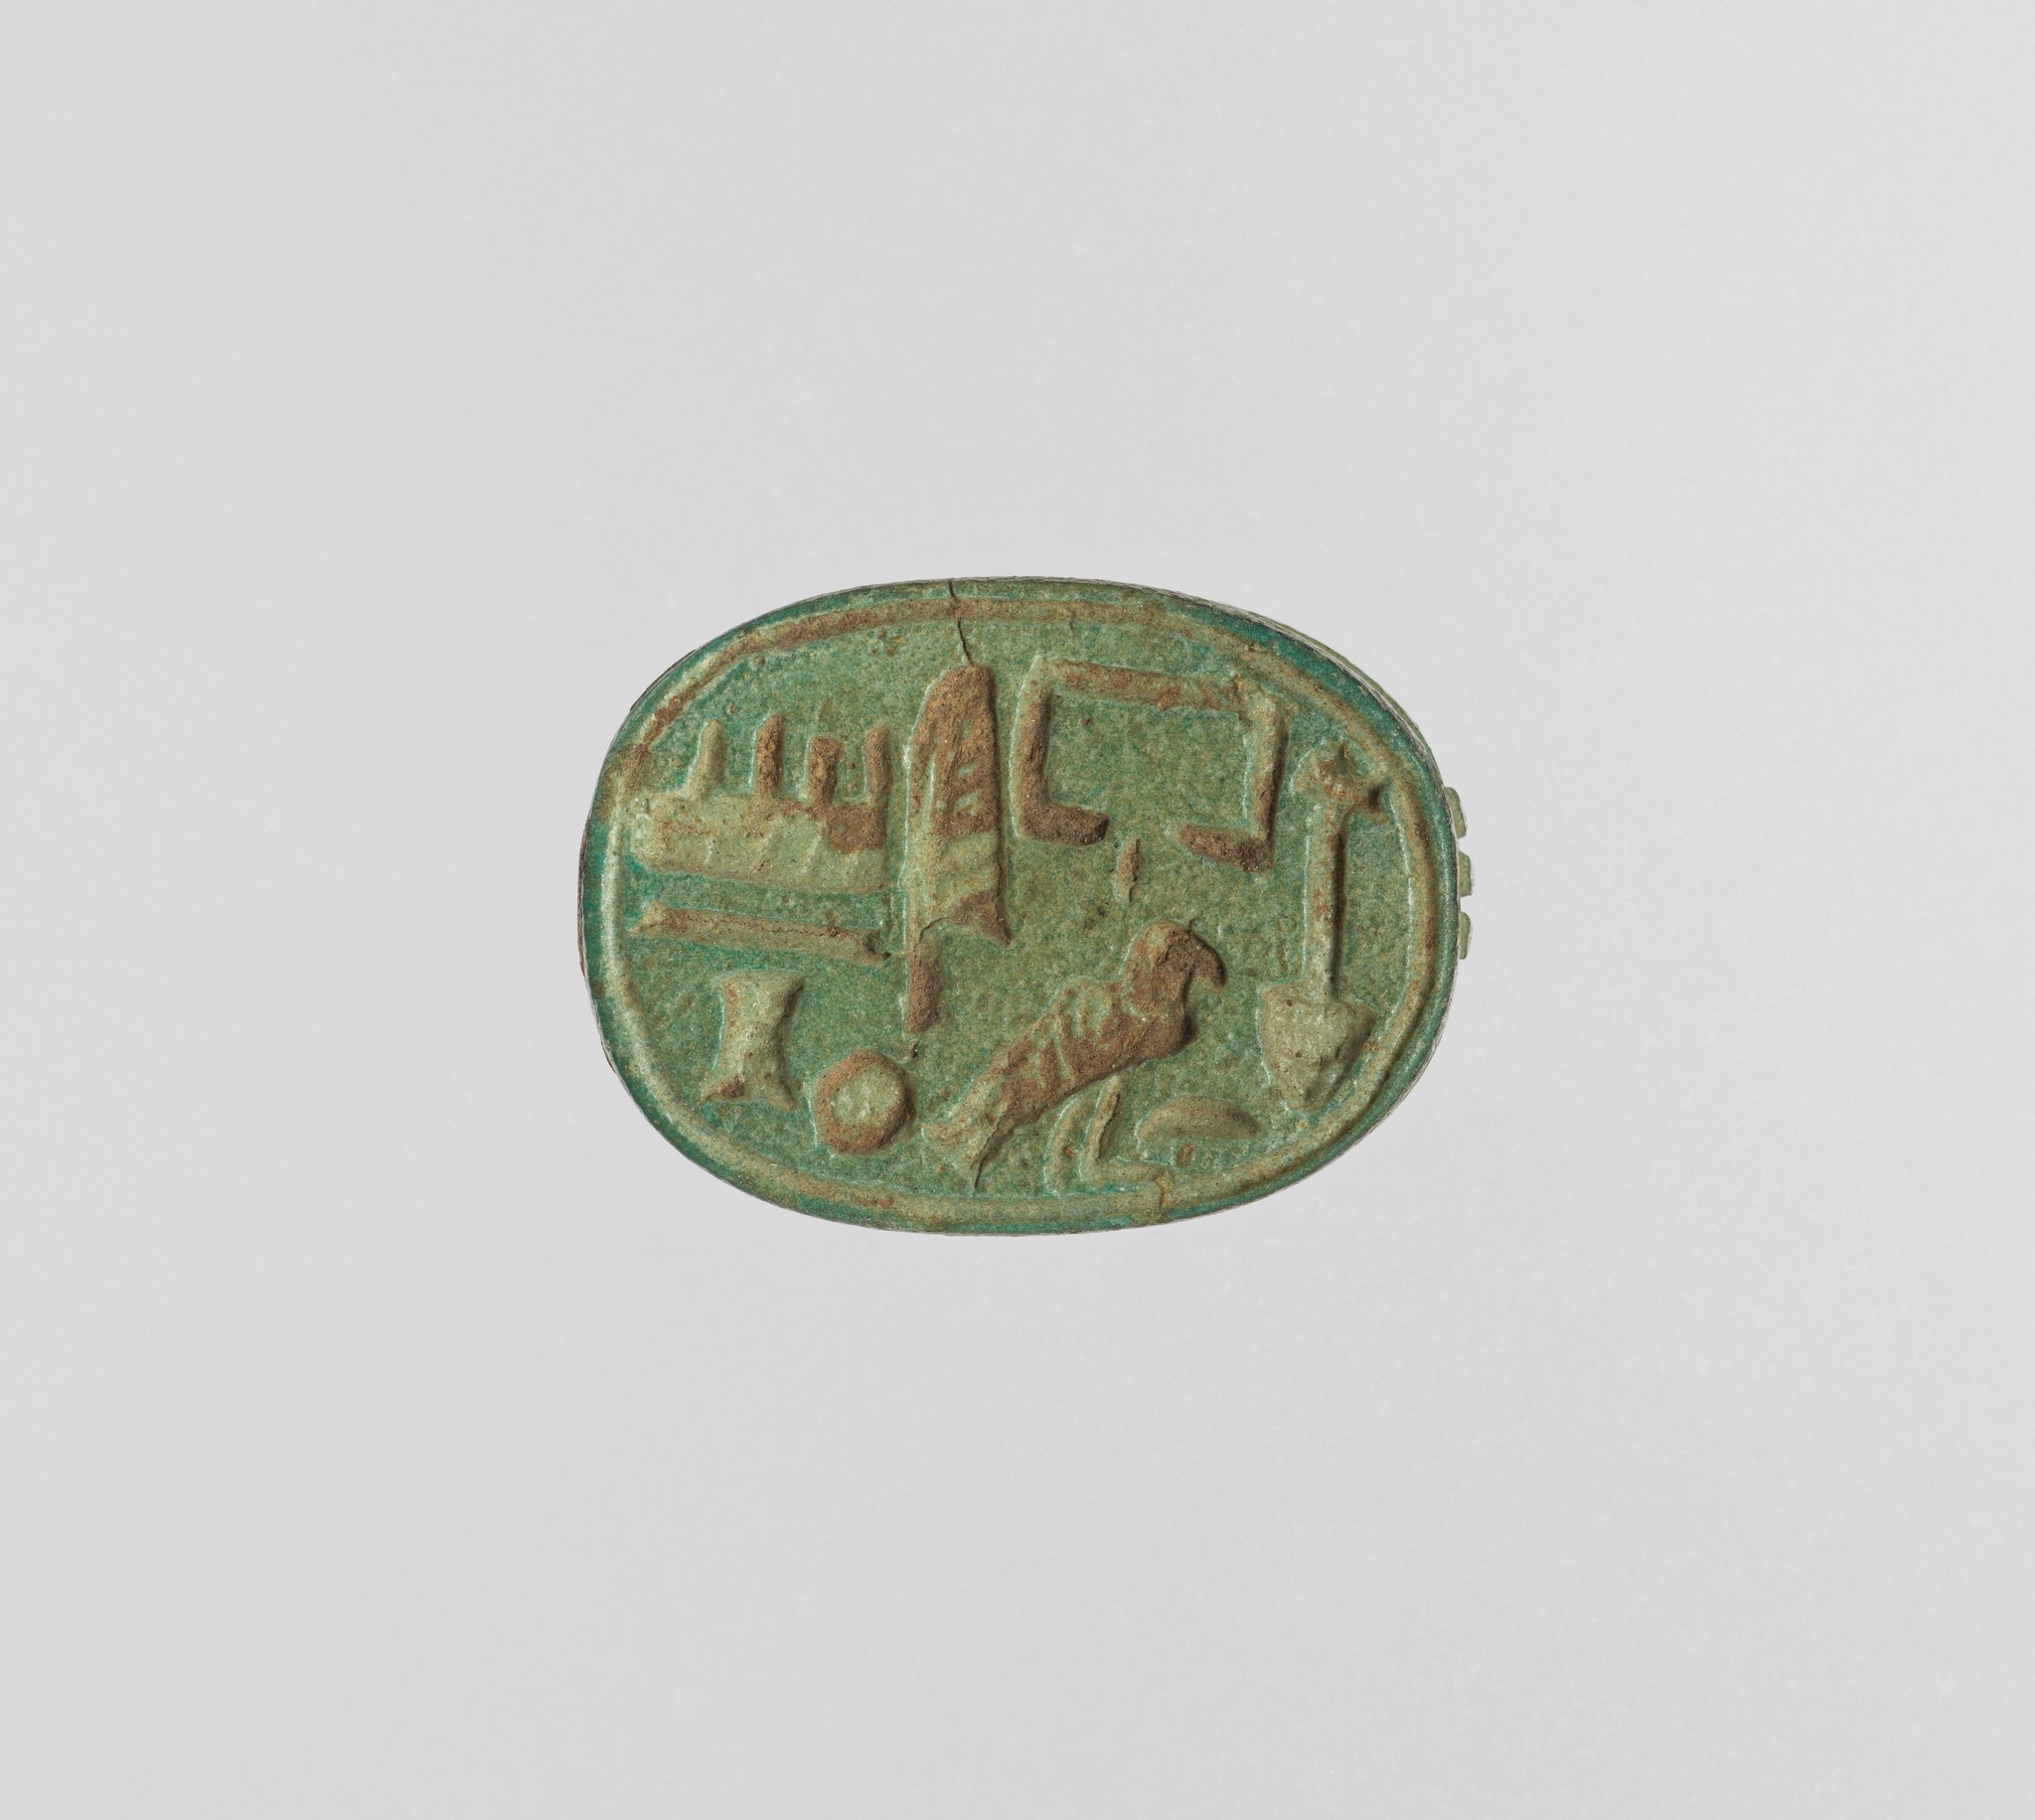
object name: scaraboid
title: Scarab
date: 1295-1070 BCE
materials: stone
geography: egypt